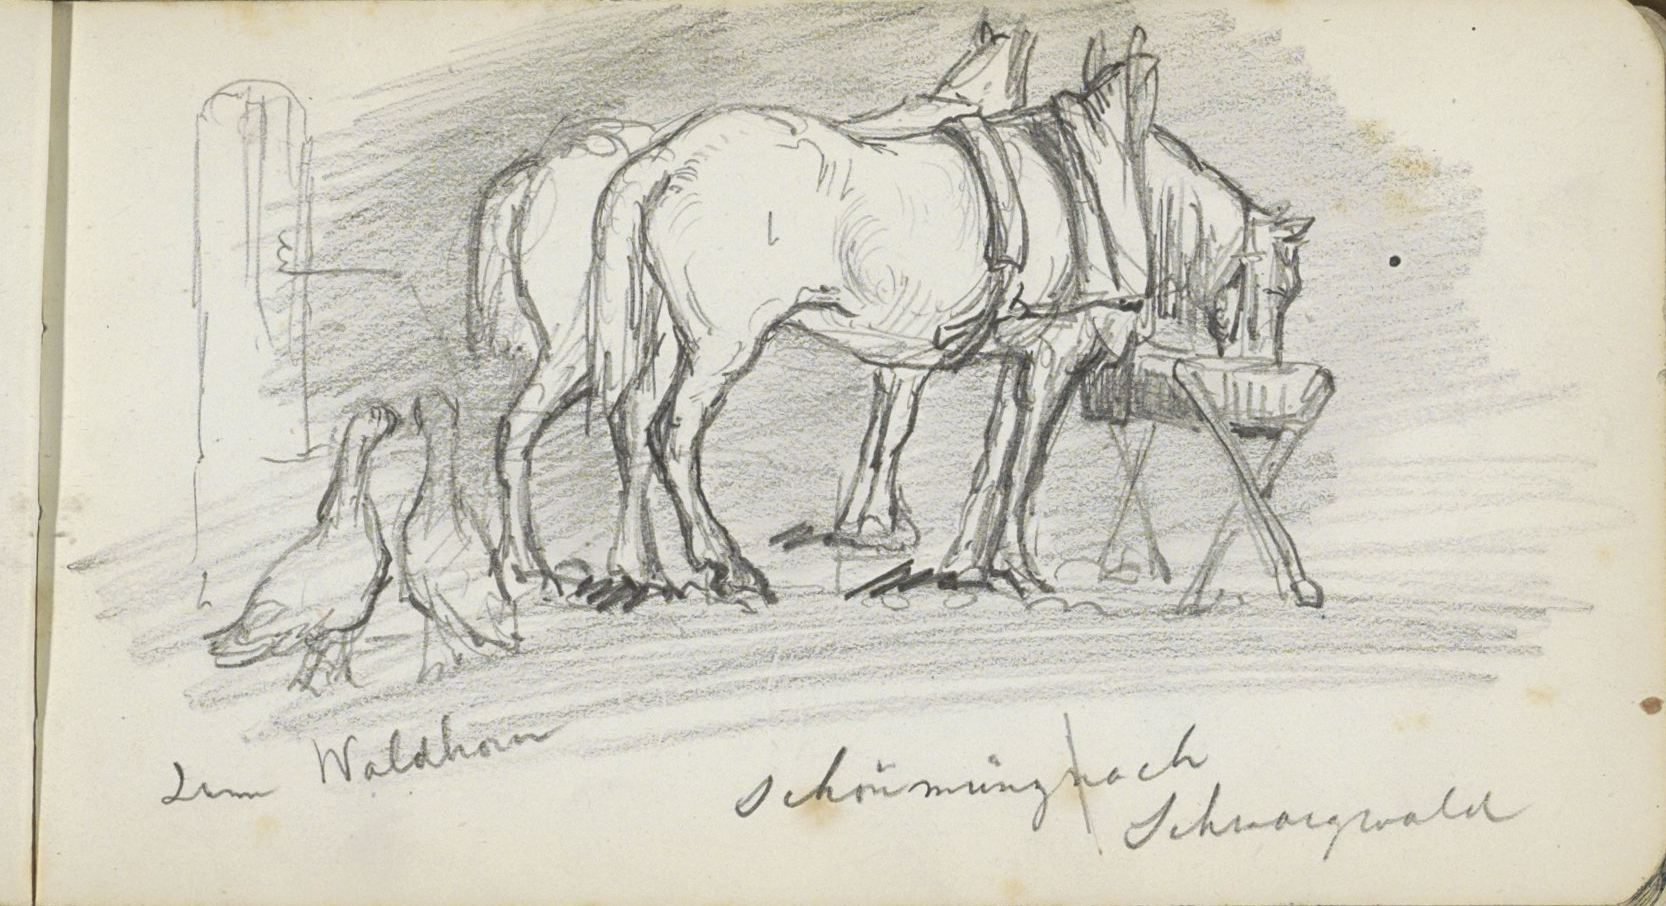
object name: sketchbook leaf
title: Twee paarden die uit een trog eten bij Schönmünzach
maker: geo poggenbeek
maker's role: draughtsman, painter, print maker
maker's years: 1853-1903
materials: paper, pencil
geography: schönmünzach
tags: trough, horse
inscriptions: annotation: ‘zul Waldhorn/ Schönmünznach/ Schwarzwald’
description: Blad 41 recto uit een schetsboek met 69 bladen.